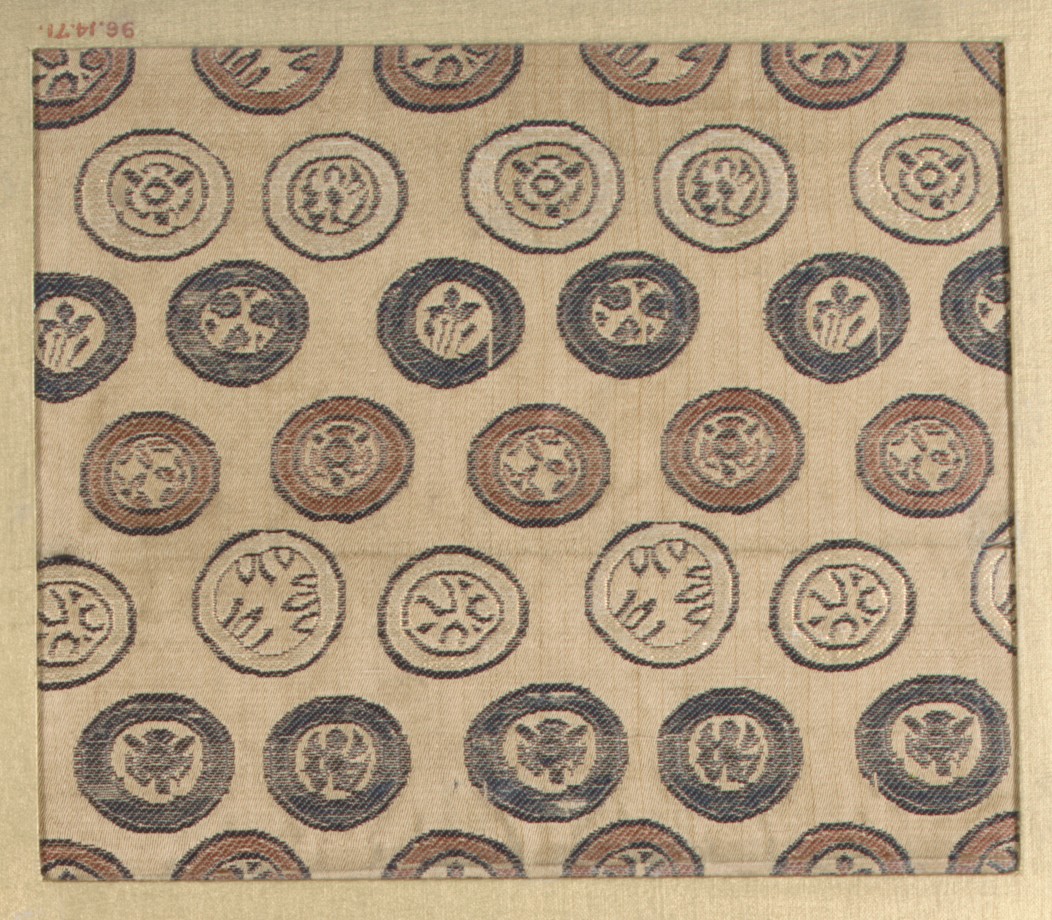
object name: piece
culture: japanese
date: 1701-1900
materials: silk